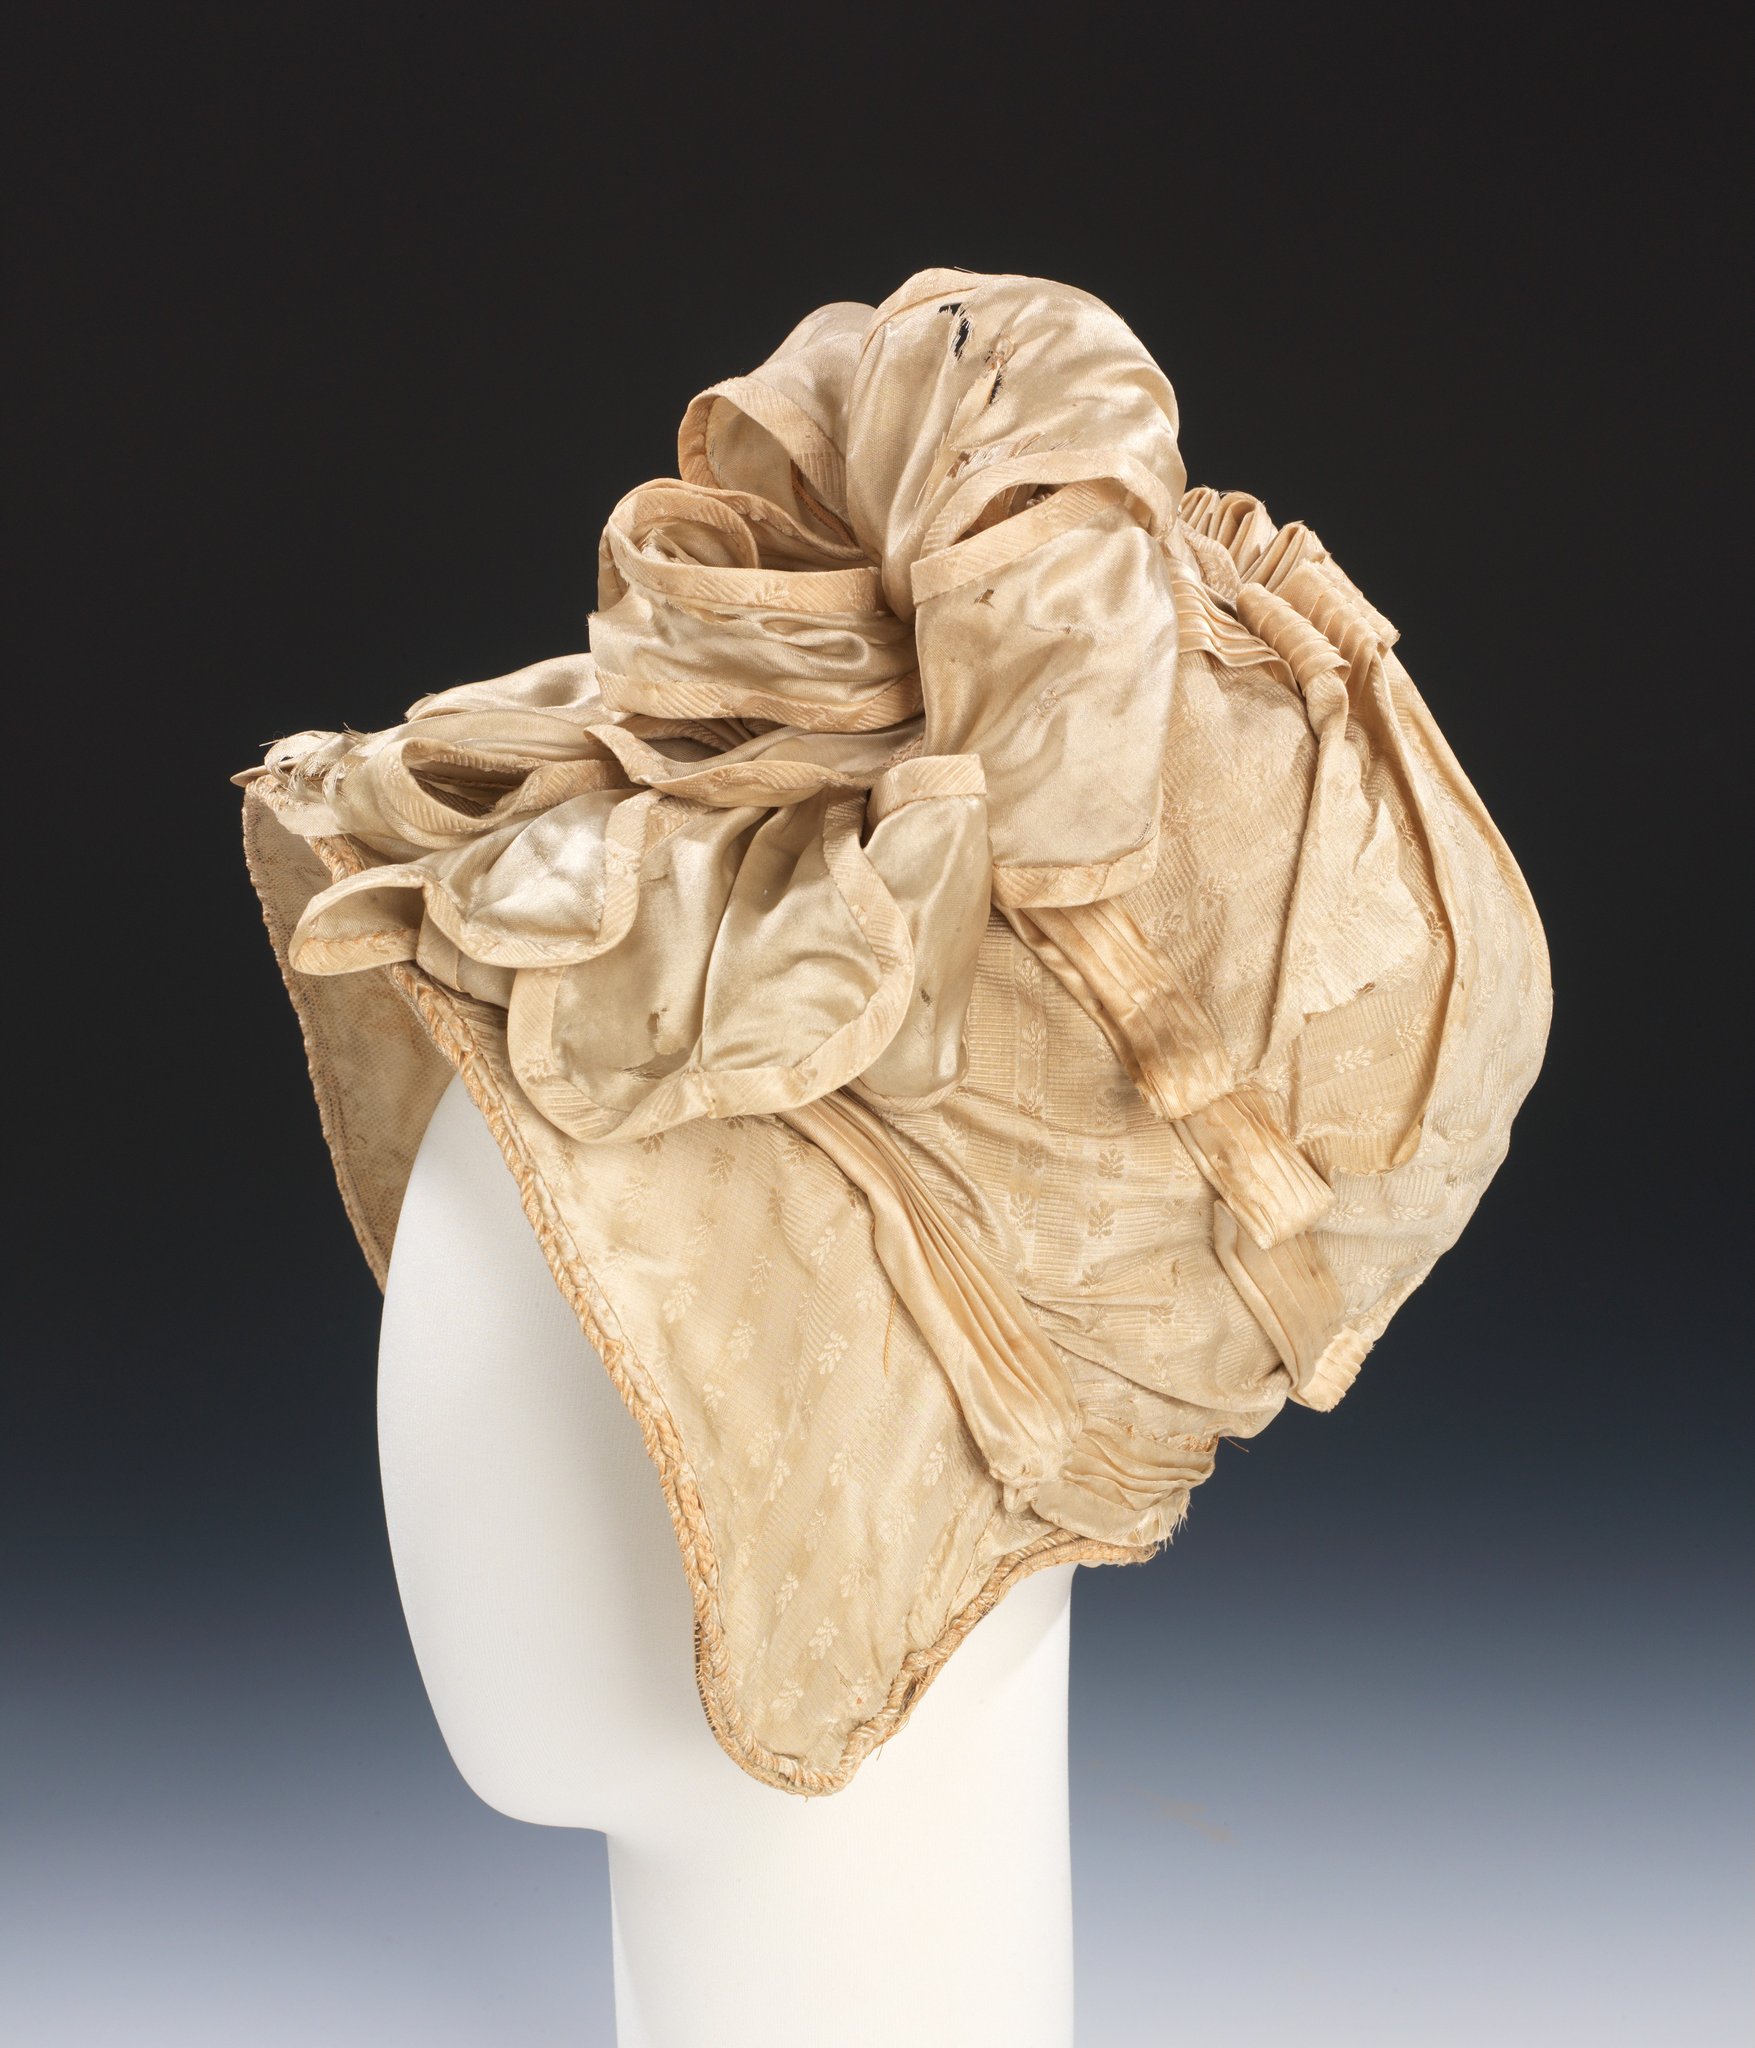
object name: bonnet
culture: american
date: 1810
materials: silk